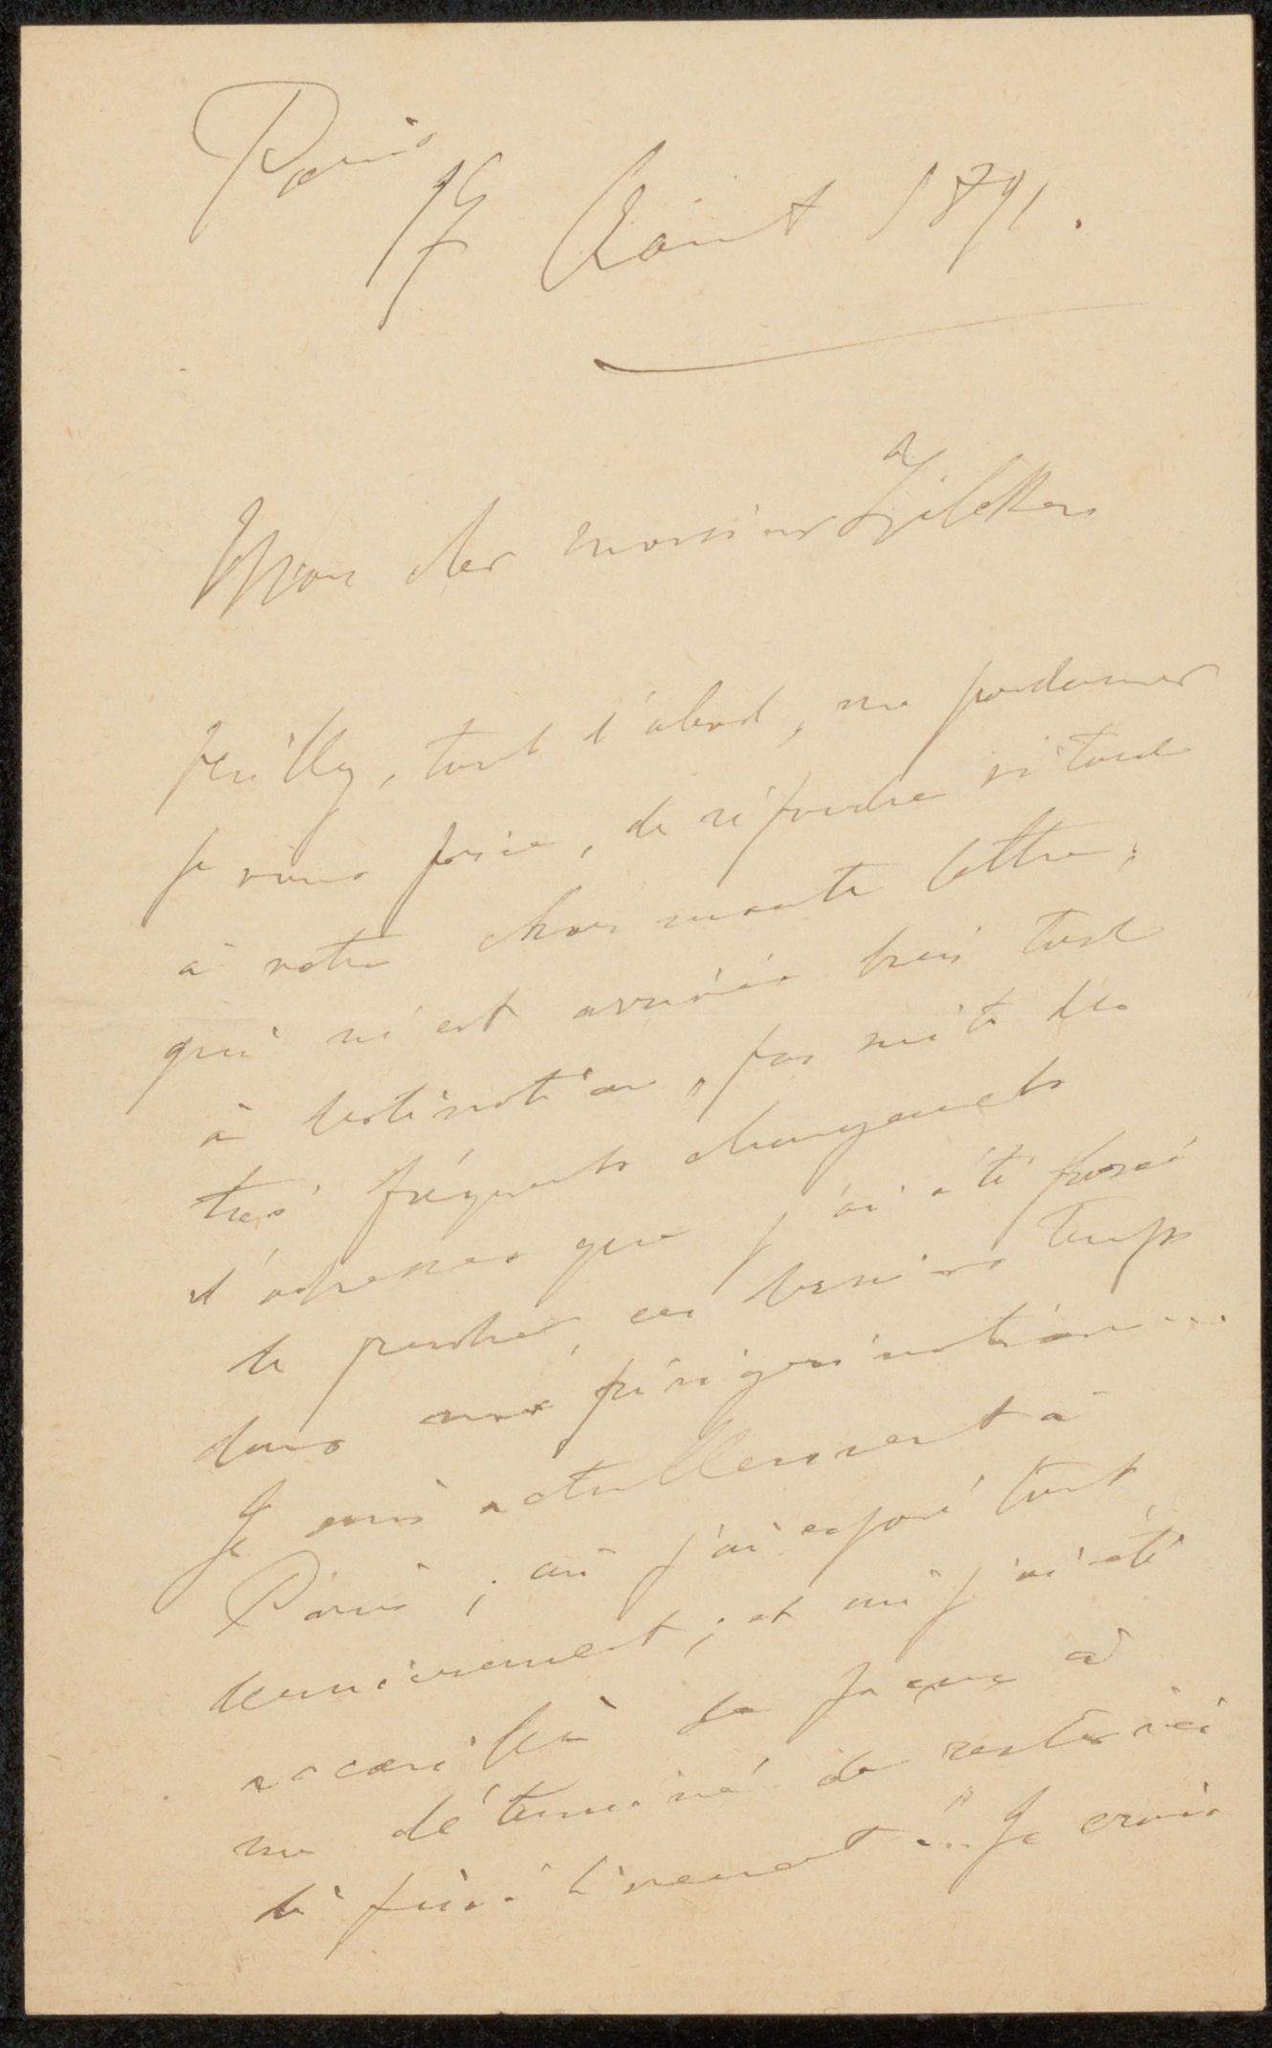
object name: letter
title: Brief aan Philip Zilcken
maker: henri de groux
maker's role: painter, print maker, sculptor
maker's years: 1866-1930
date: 1891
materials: ink, paper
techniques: pen, writing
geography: paris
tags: the hague, painter, draughtsman, philip zilcken, paris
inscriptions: collector's mark: ‘RPK’